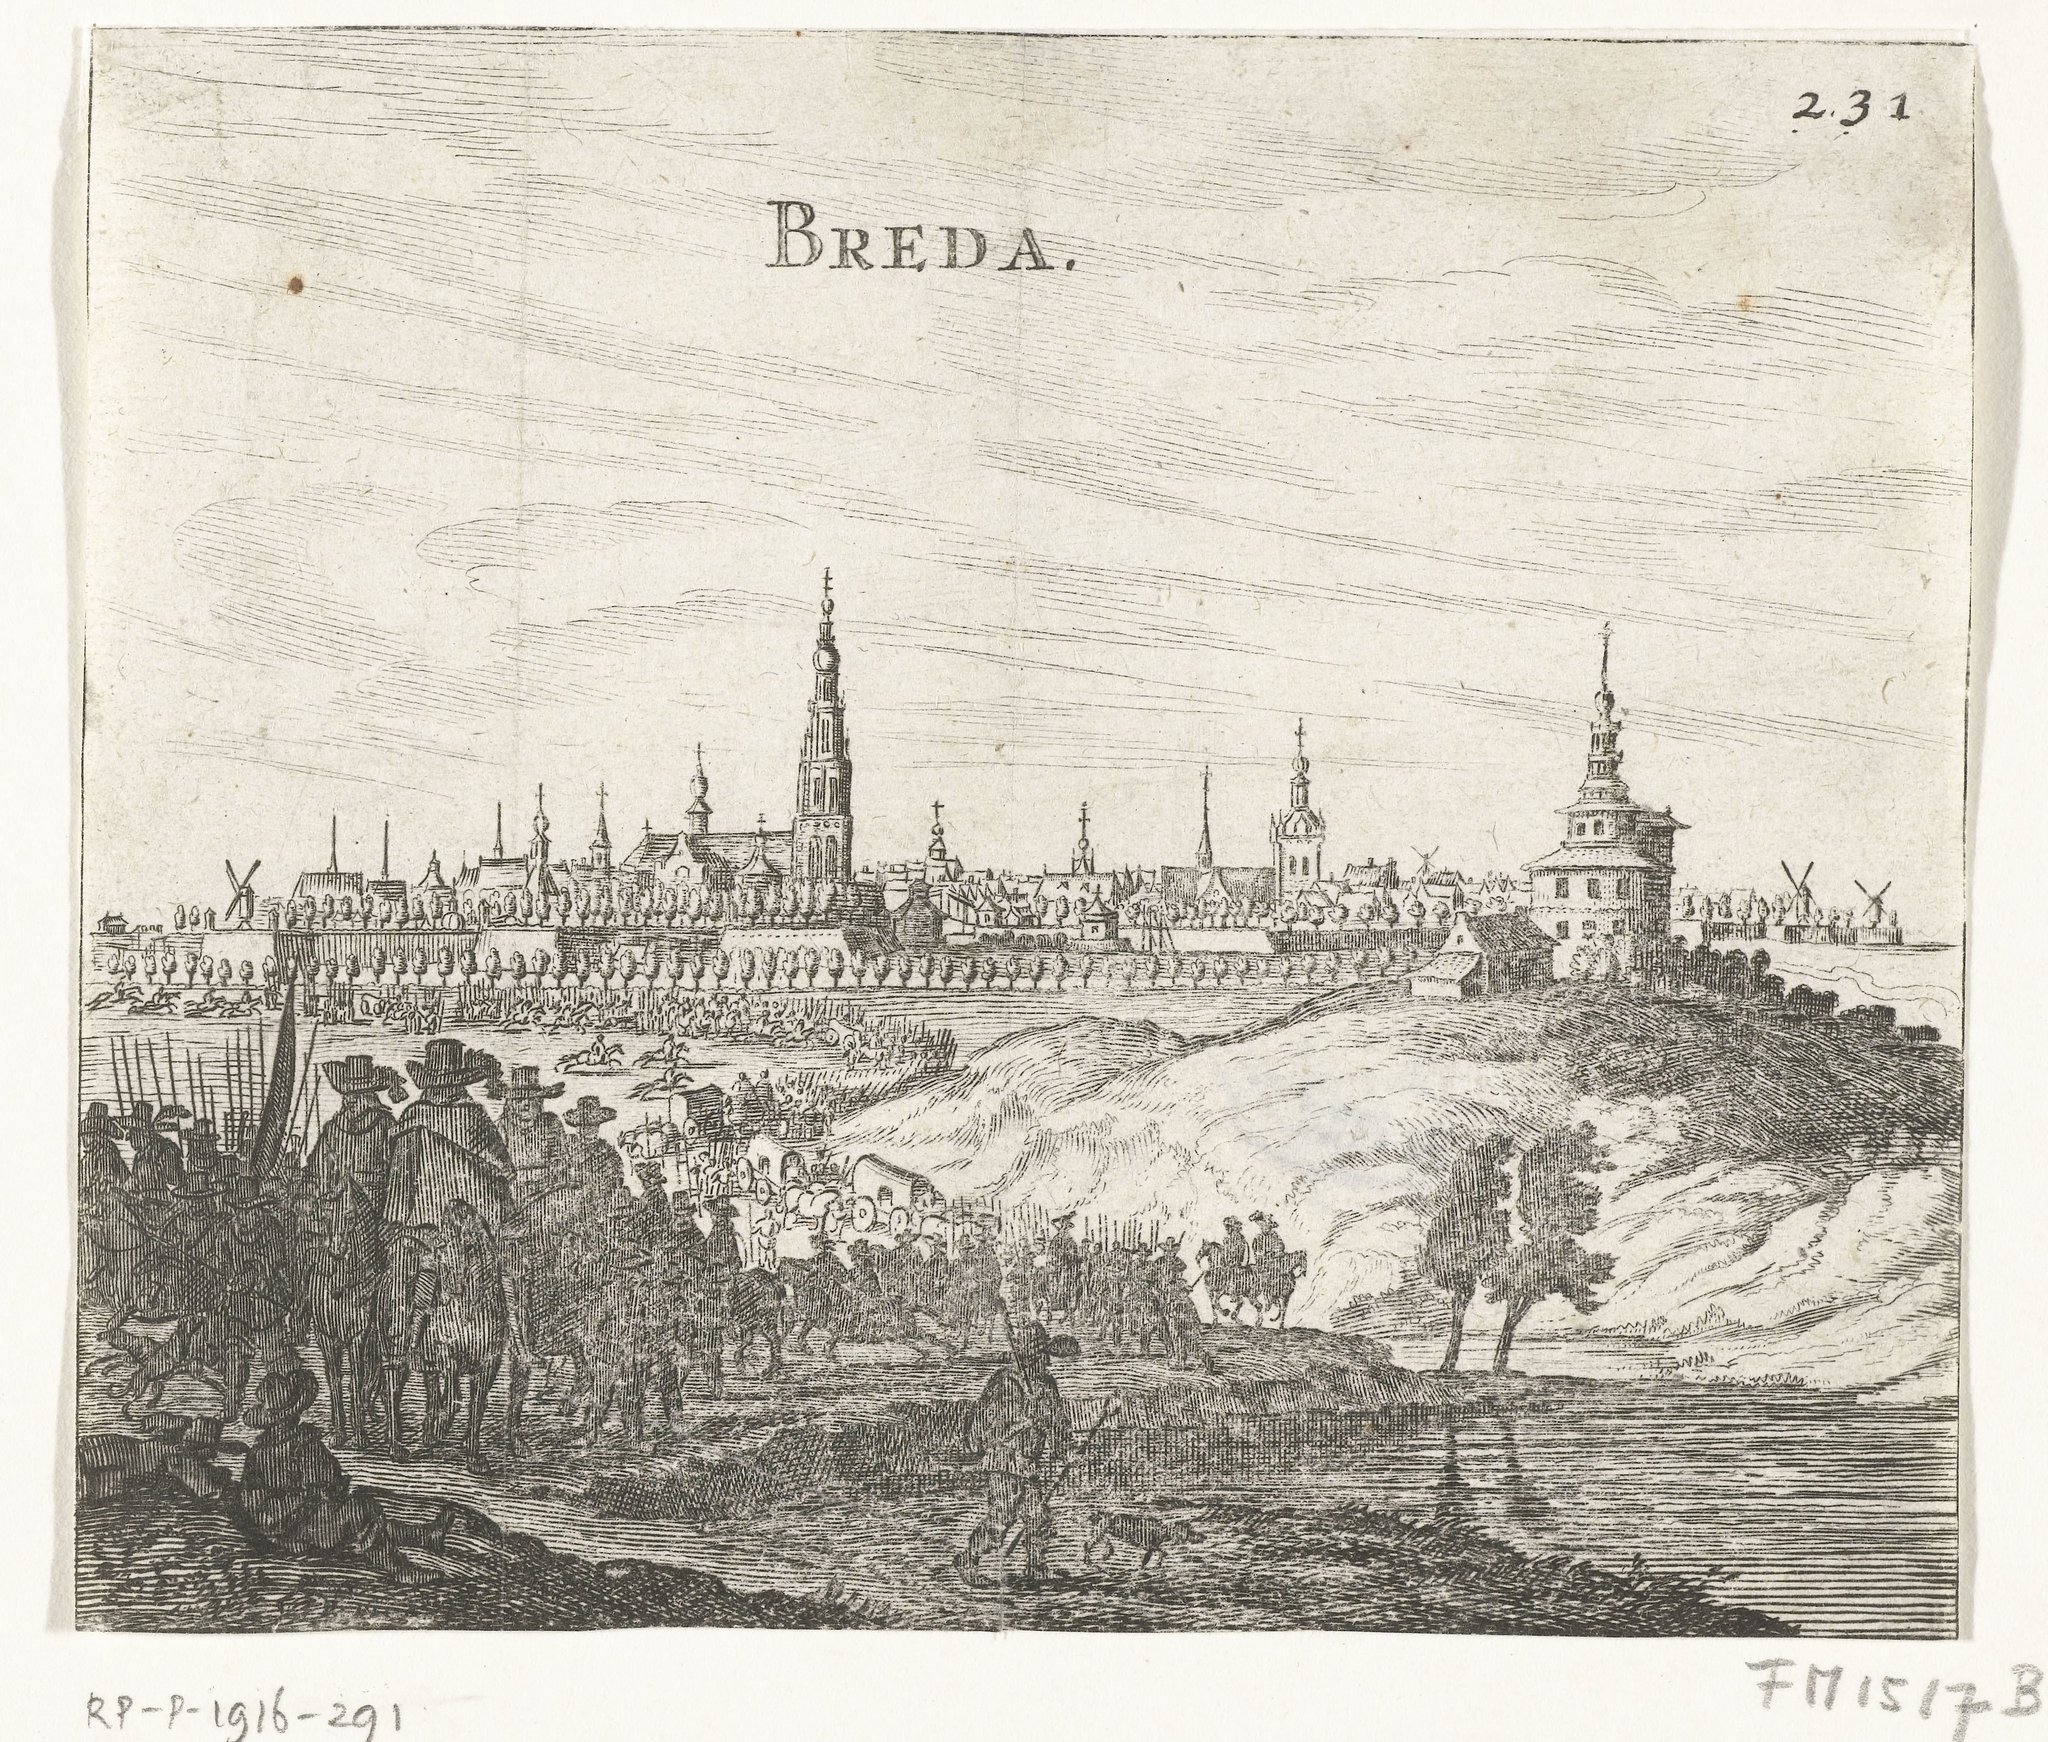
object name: history print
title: Beleg van Breda, 1624-1625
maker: Anonymous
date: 1650-1664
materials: paper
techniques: engraving, etching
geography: northern netherlands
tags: siege, position war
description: Gebruikt als illustratie in: A. Montanus, 'T leven en bedryf der prinsen van Oranje, Wilhelm de eerste, Maurits, Frederik Henrik, Wilhem de tweede, Wilhem de derde : aengehecht met de daden der Nassouwsche stam, van het jaar 682 tot dese tyd, Amsterdam 1664, dl. II, p. 232/233 (exemplaar in Rijksmuseum Research Library 330 F 12-13). Niet in Frederik Muller; door het RPK toegevoegd nummer.